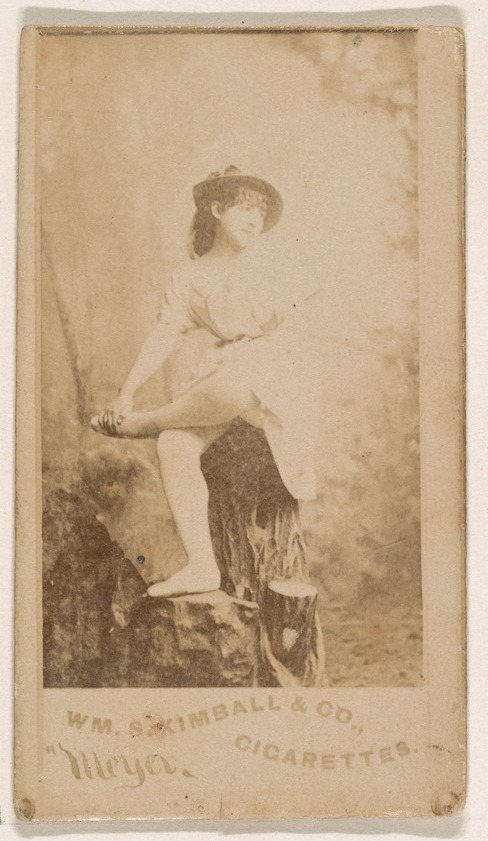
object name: photograph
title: Miss Meyer, from the Actresses series (N203) issued by Wm. S. Kimball & Co.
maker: william s. kimball & company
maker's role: publisher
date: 1889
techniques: color lithograph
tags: portraits,women,actresses